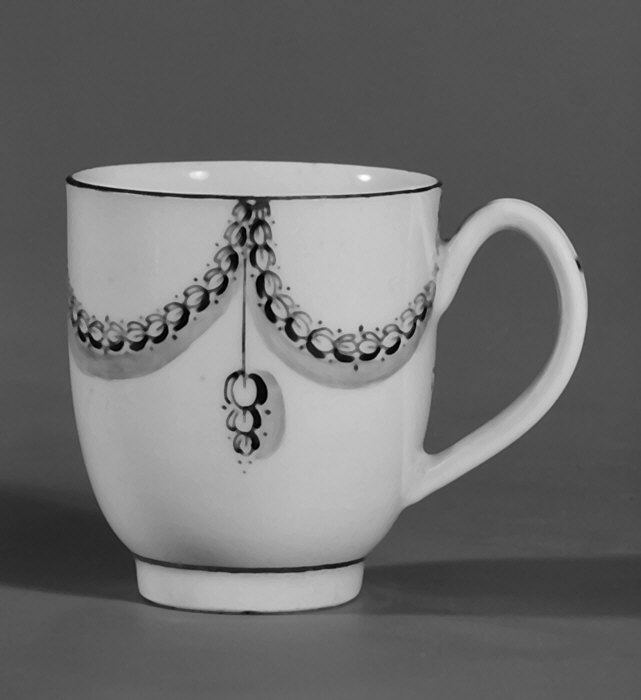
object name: coffee cup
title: Coffee cup (part of a service)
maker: caughley factory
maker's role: factory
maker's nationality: british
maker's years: 1772-1799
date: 1780-1790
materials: soft paste porcelain